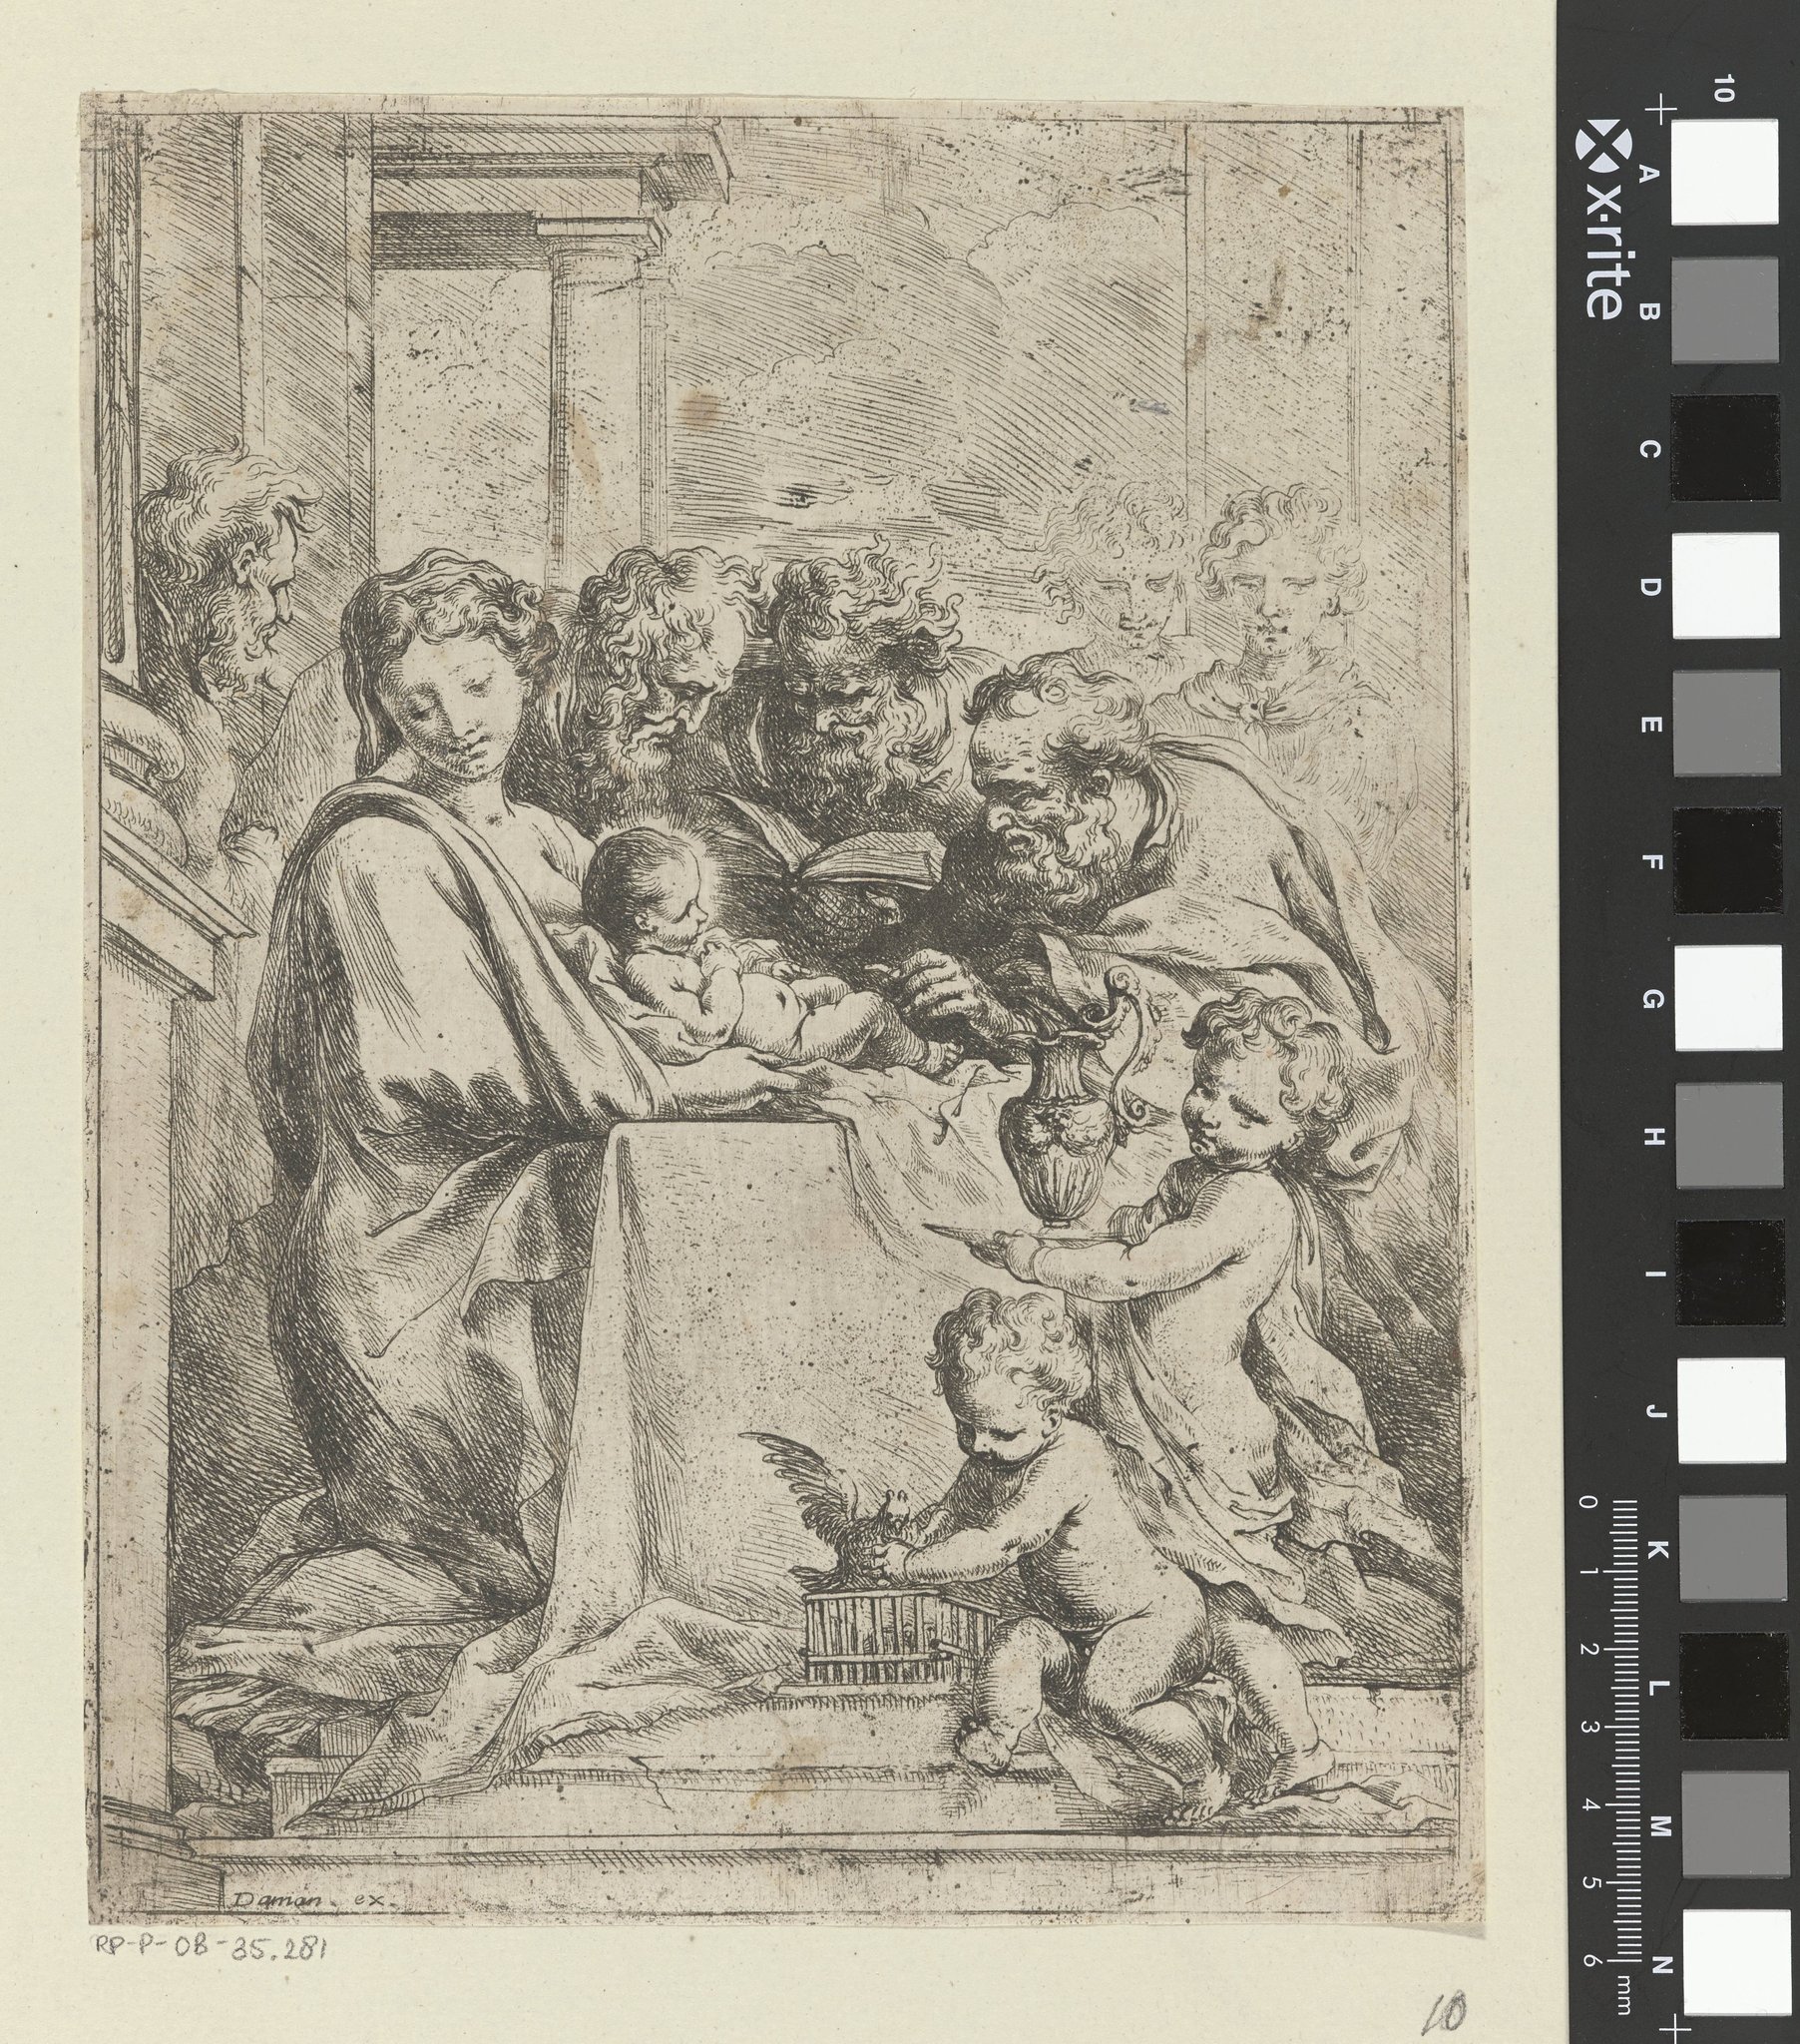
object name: print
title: Besnijdenis van Christus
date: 1642-1657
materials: paper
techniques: etching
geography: italy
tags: circumcision of the christ-child by the priest in the temple (luke 2:21)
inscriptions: collector's mark: Lugt 240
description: Maria zit geknield bij een tafel waarop het Christuskind wordt besneden door de hogepriester. Achter de hogepriester een tweede priester die een boek leest, Jozef en twee jongemannen. Op de voorgrond twee putti met een kooi met duif en een kan.